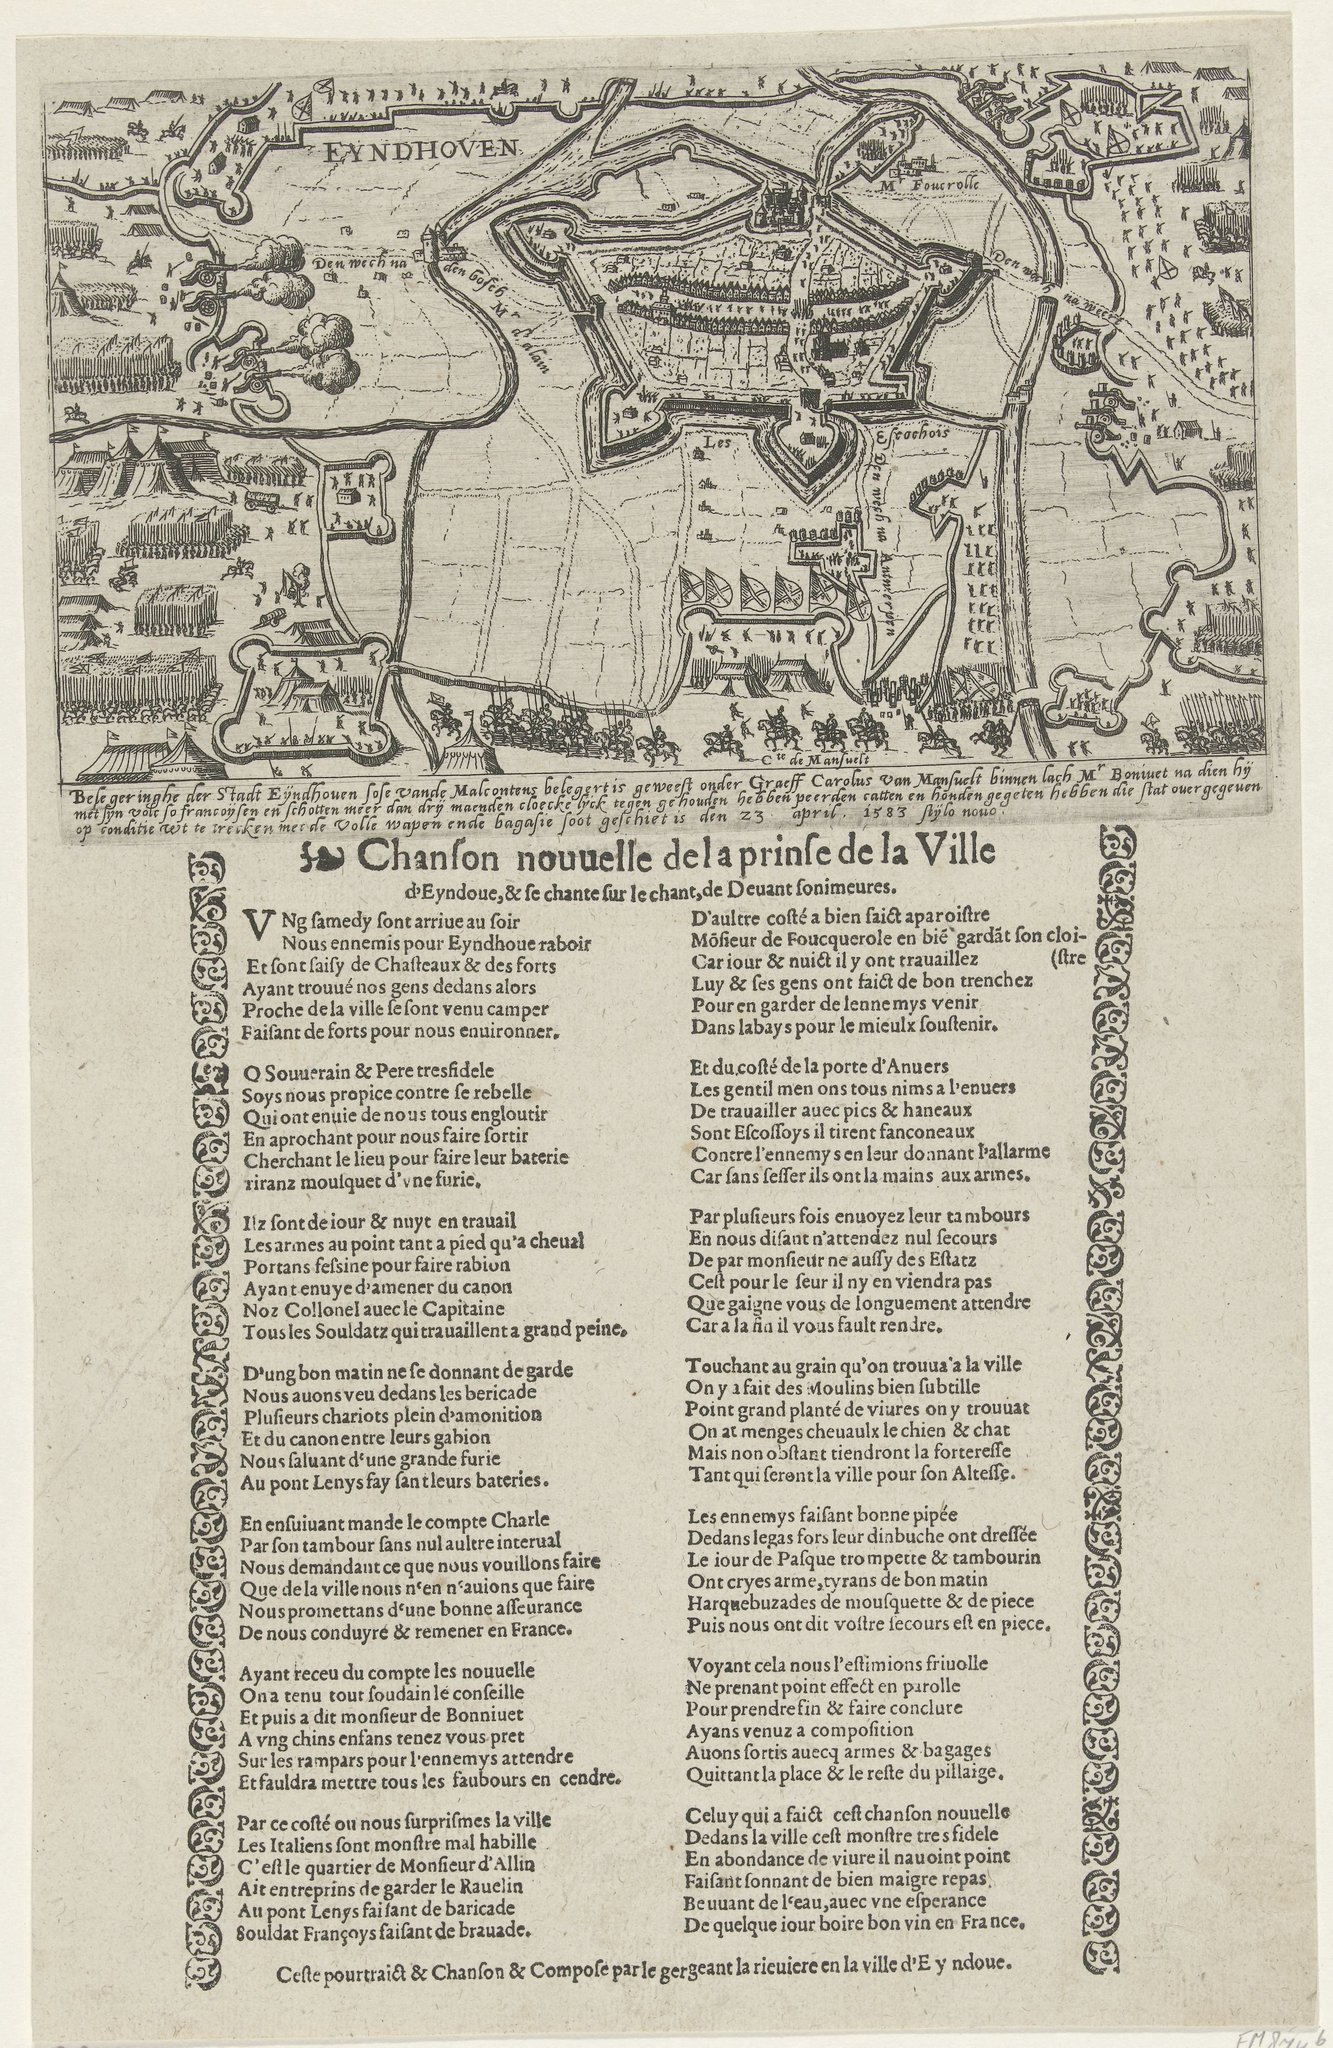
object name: song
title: Beleg van Eindhoven met lied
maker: Anonymous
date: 1583-1615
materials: paper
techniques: etching, letterpress printing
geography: low countries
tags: siege, position war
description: Eindhoven belegerd en ingenomen door Karel, graaf van Mansveld, 23 april 1583. De troepen onder Bonnivet verdedigen de stad. Met onderschrift van 3 regels in het Nederlands. Onder de prent een tekstblad met een lied op de verovering van de stad, 14 verzen van 6 regels in het Frans.